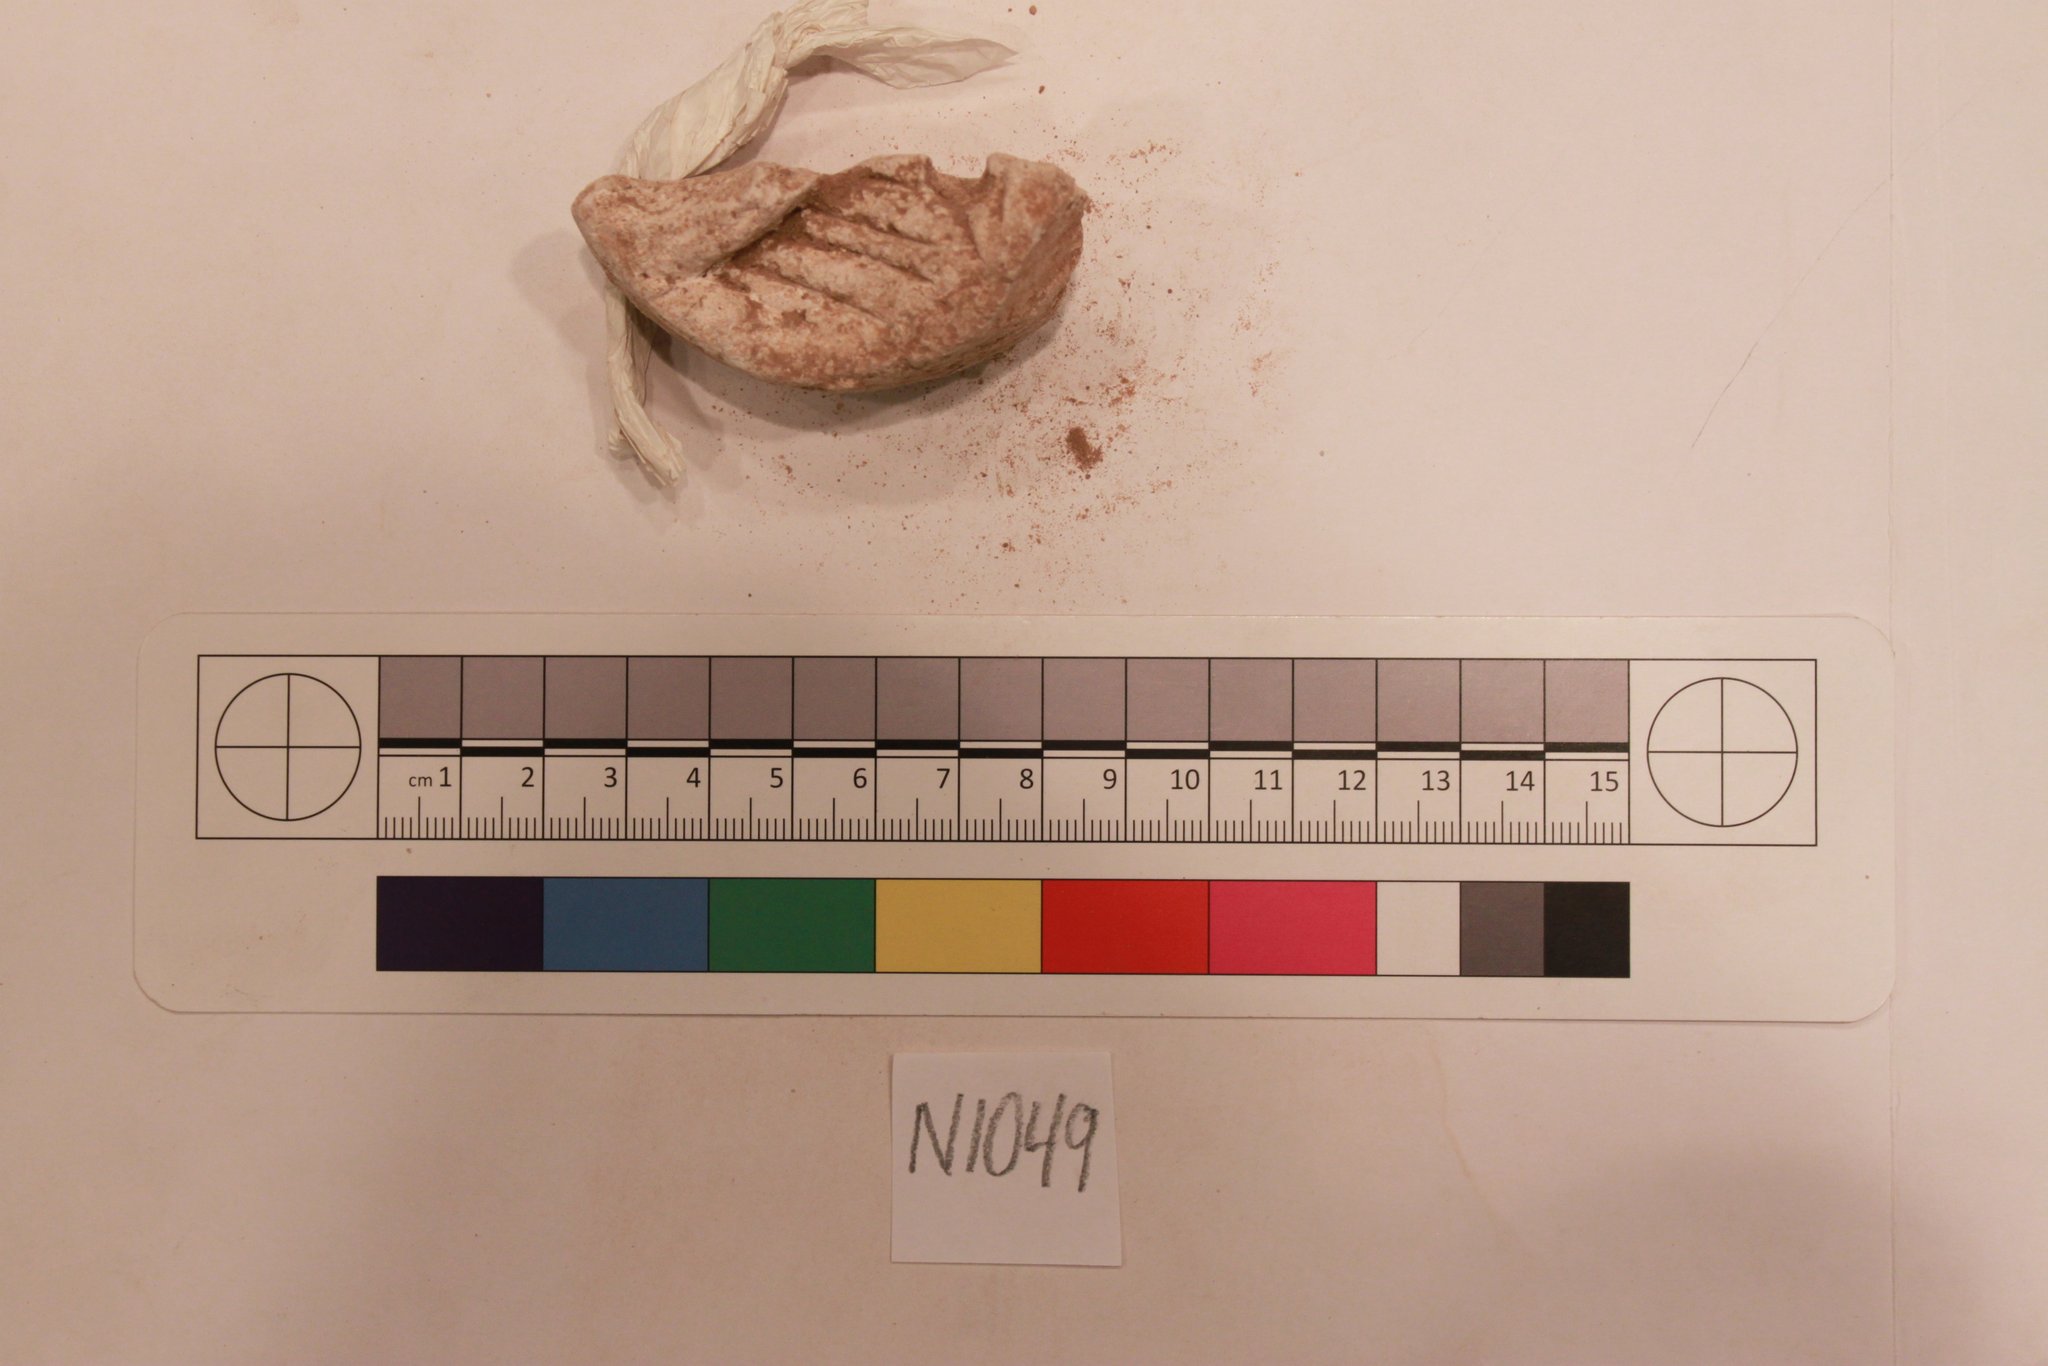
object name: fragment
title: Stucco Fragment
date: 701-1200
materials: plaster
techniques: carving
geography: iran